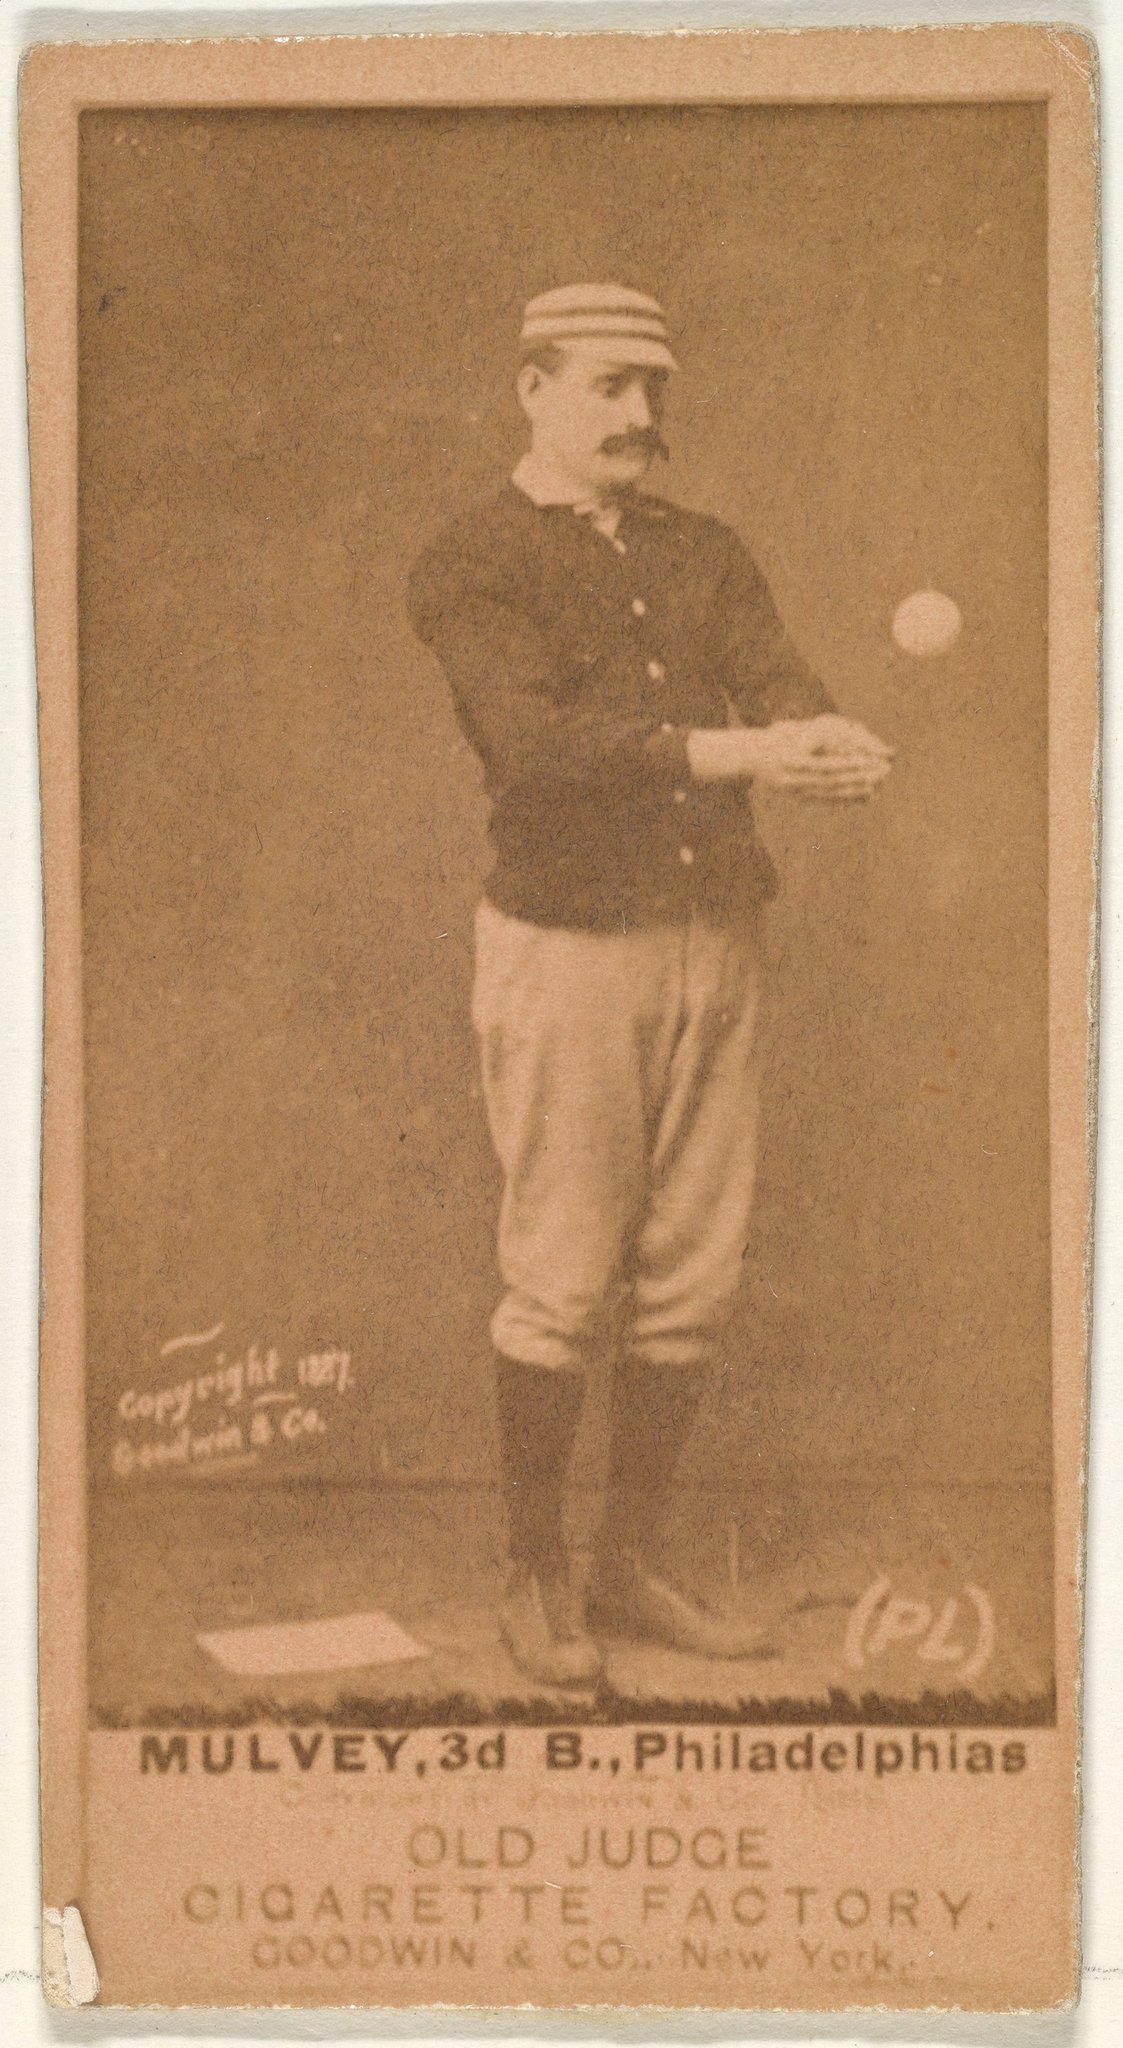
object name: baseball card, photograph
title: Joseph H. "Joe" Mulvey, 3rd Base, Philadelphia, from the Old Judge series (N172) for Old Judge Cigarettes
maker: goodwin & company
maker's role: publisher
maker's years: 1850-1950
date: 1887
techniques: albumen silver print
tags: men,portraits,baseball,athletes